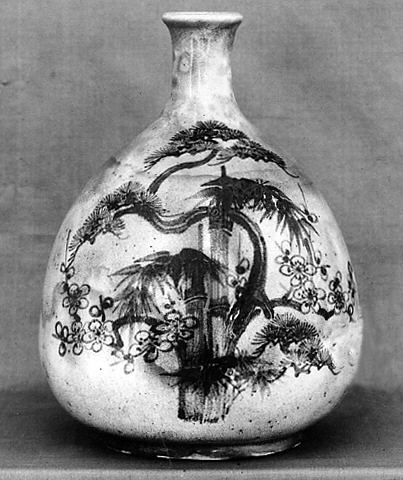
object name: bottle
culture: japanese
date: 1801-1900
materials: glaze, pottery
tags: flowers